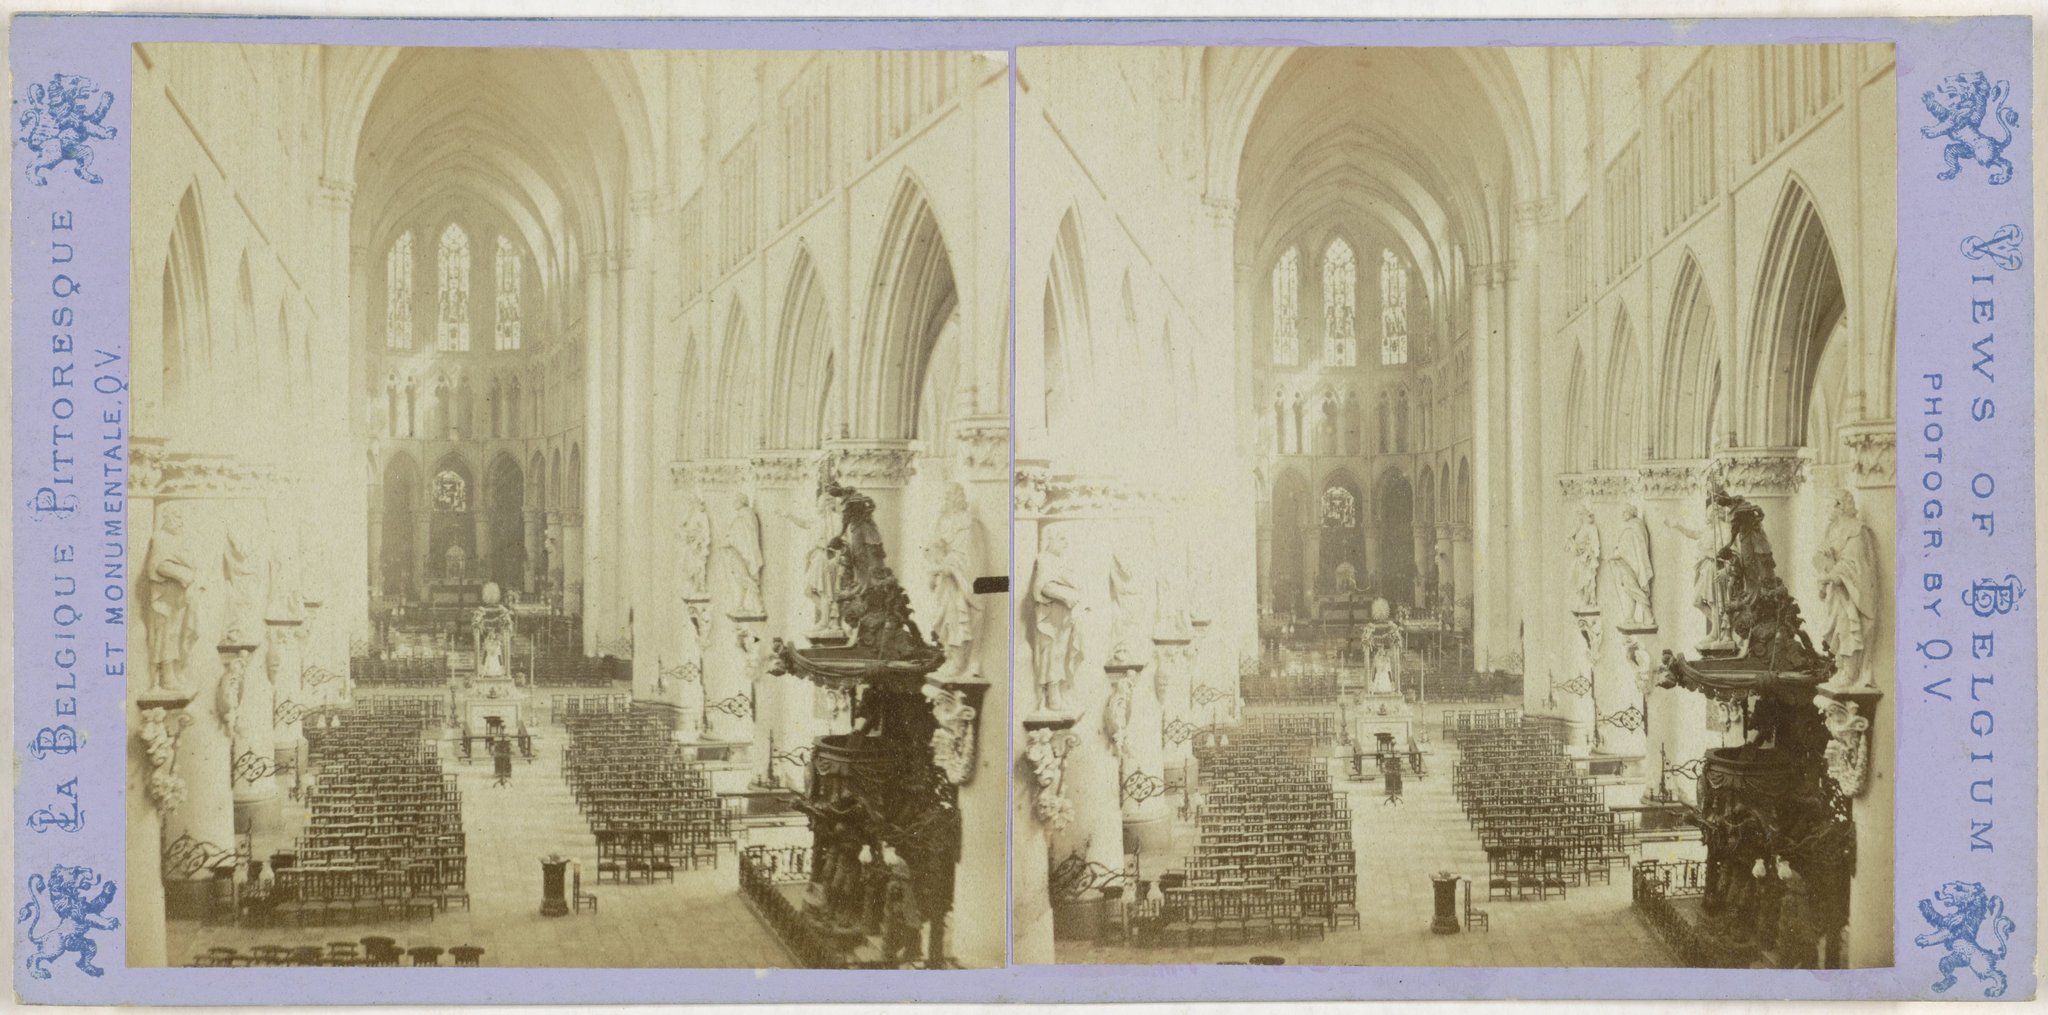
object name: stereograph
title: Bruxelles, Église Sainte-Gudule, vue intérieure prise de l'orgue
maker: jules hippolyte quéval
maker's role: publisher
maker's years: 1824-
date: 1866-1870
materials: cardboard, paper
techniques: albumen print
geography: brussels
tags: parts of church interior: nave, pulpit, ambo, chancel, parts of church interior: choir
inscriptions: number: ‘No 1603’